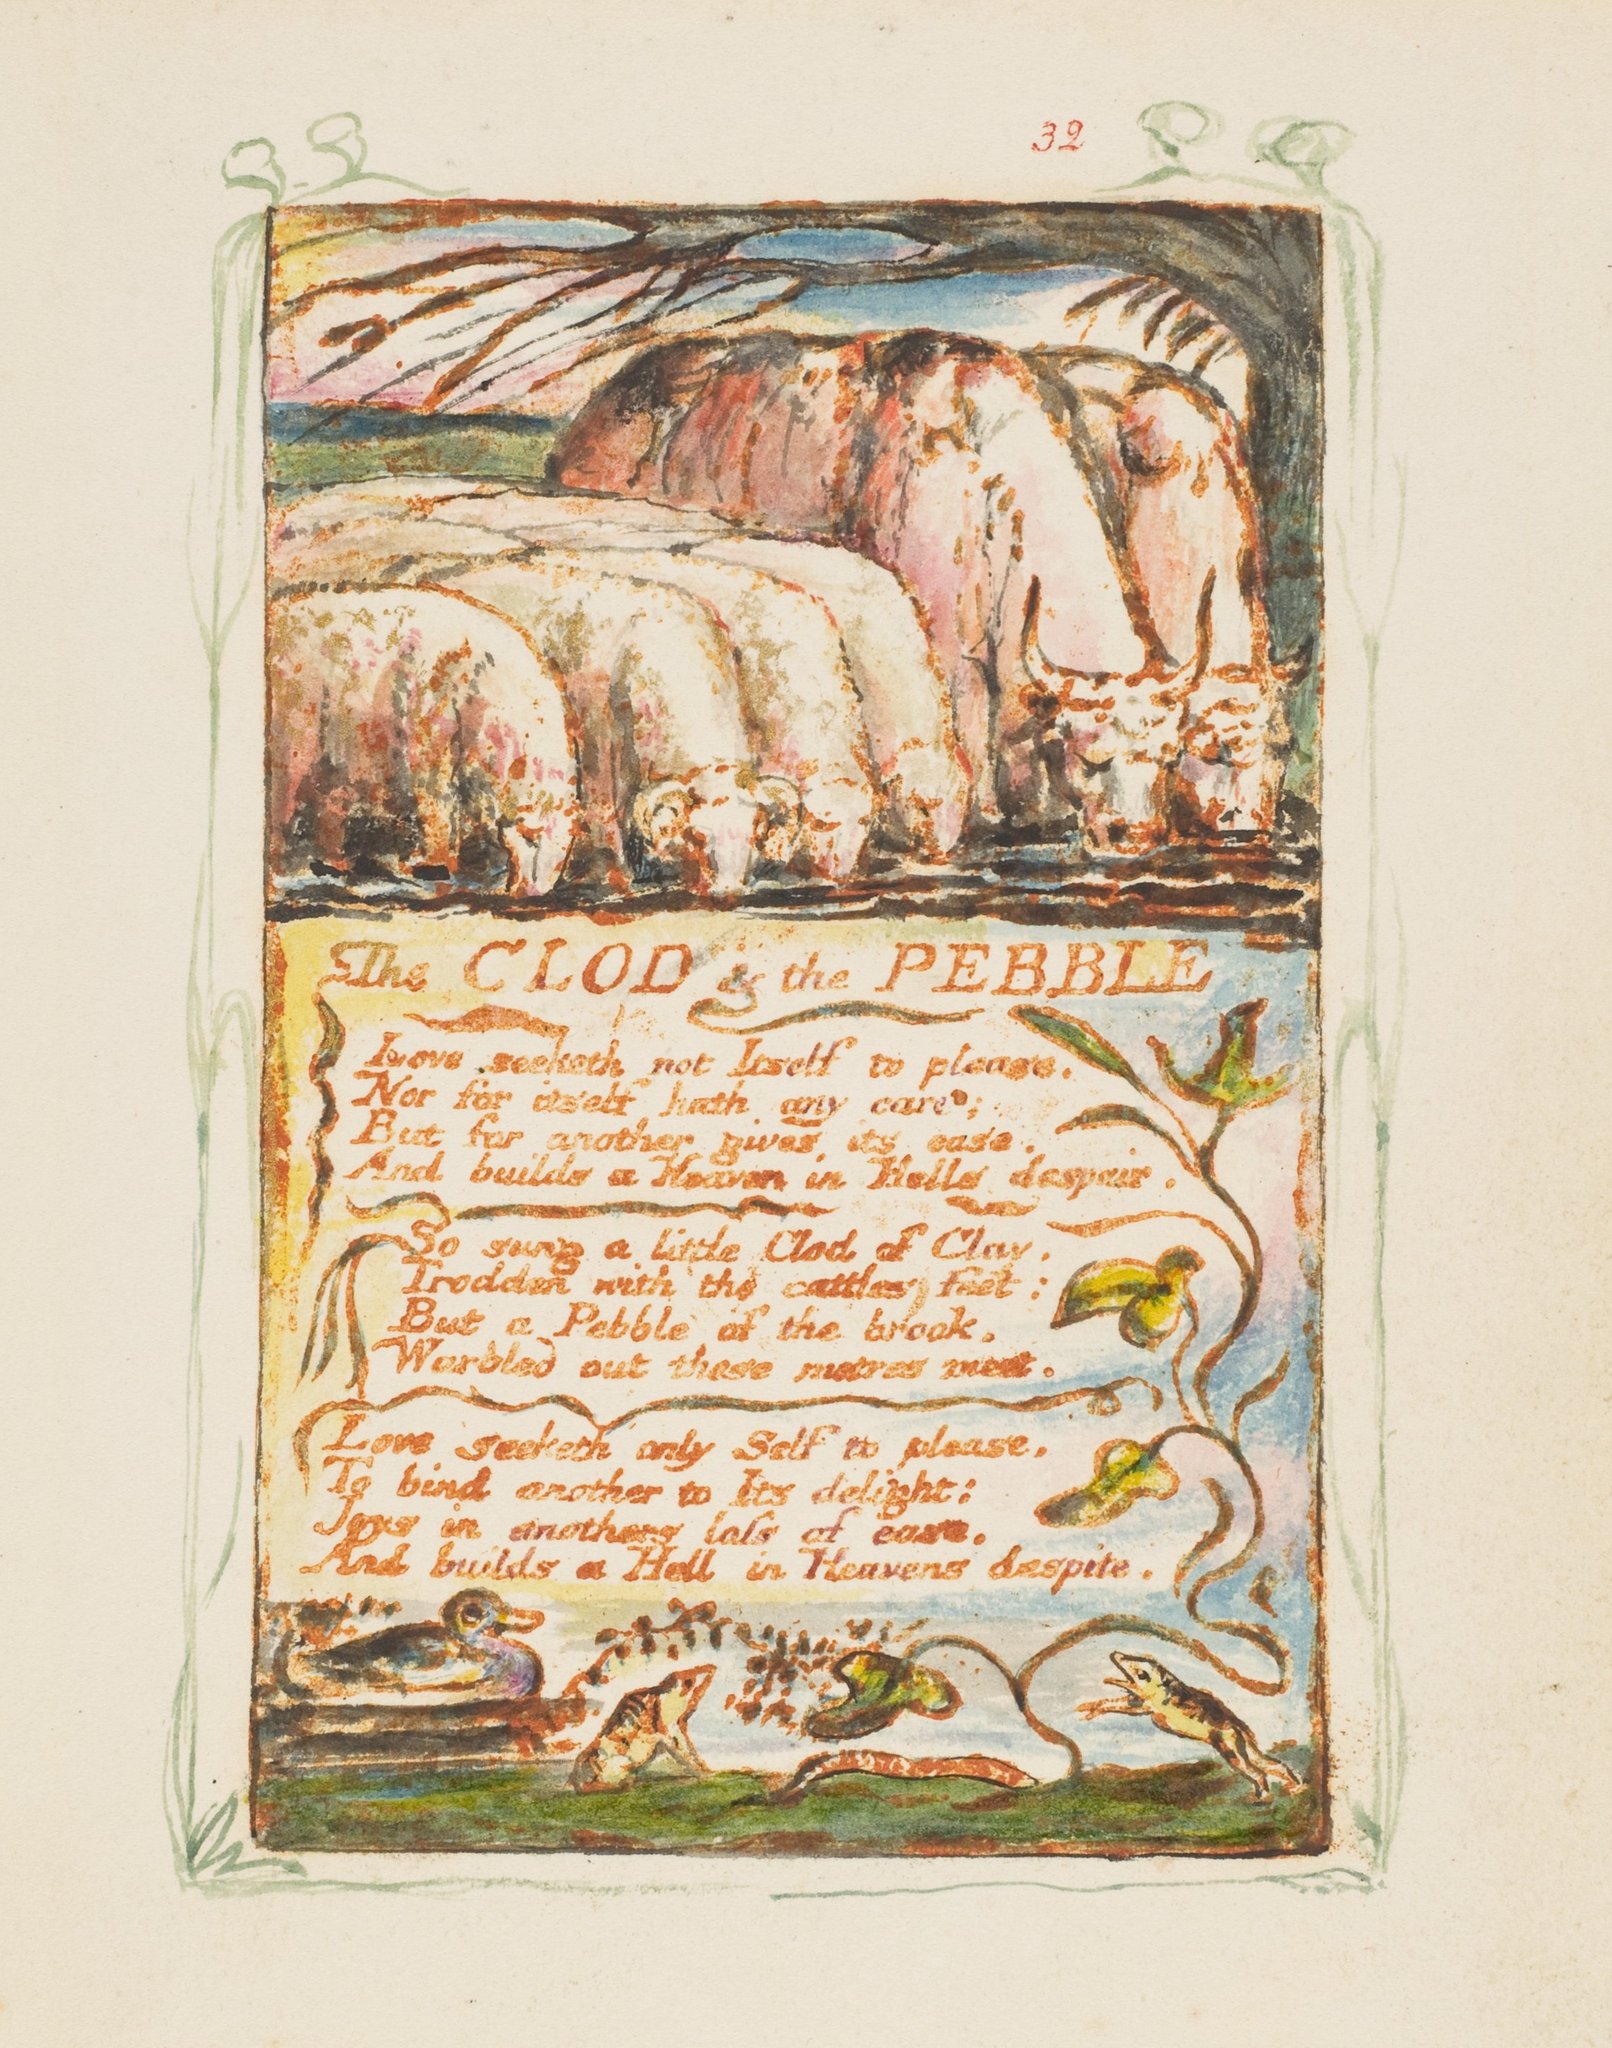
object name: print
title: Songs of Experience: The Clod & the Pebble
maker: william blake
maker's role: artist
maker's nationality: british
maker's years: 1757-1827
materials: gold, ink, shell, watercolor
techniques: etching, hand coloring, printing, relief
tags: ducks,poetry,cows,frogs,sheep